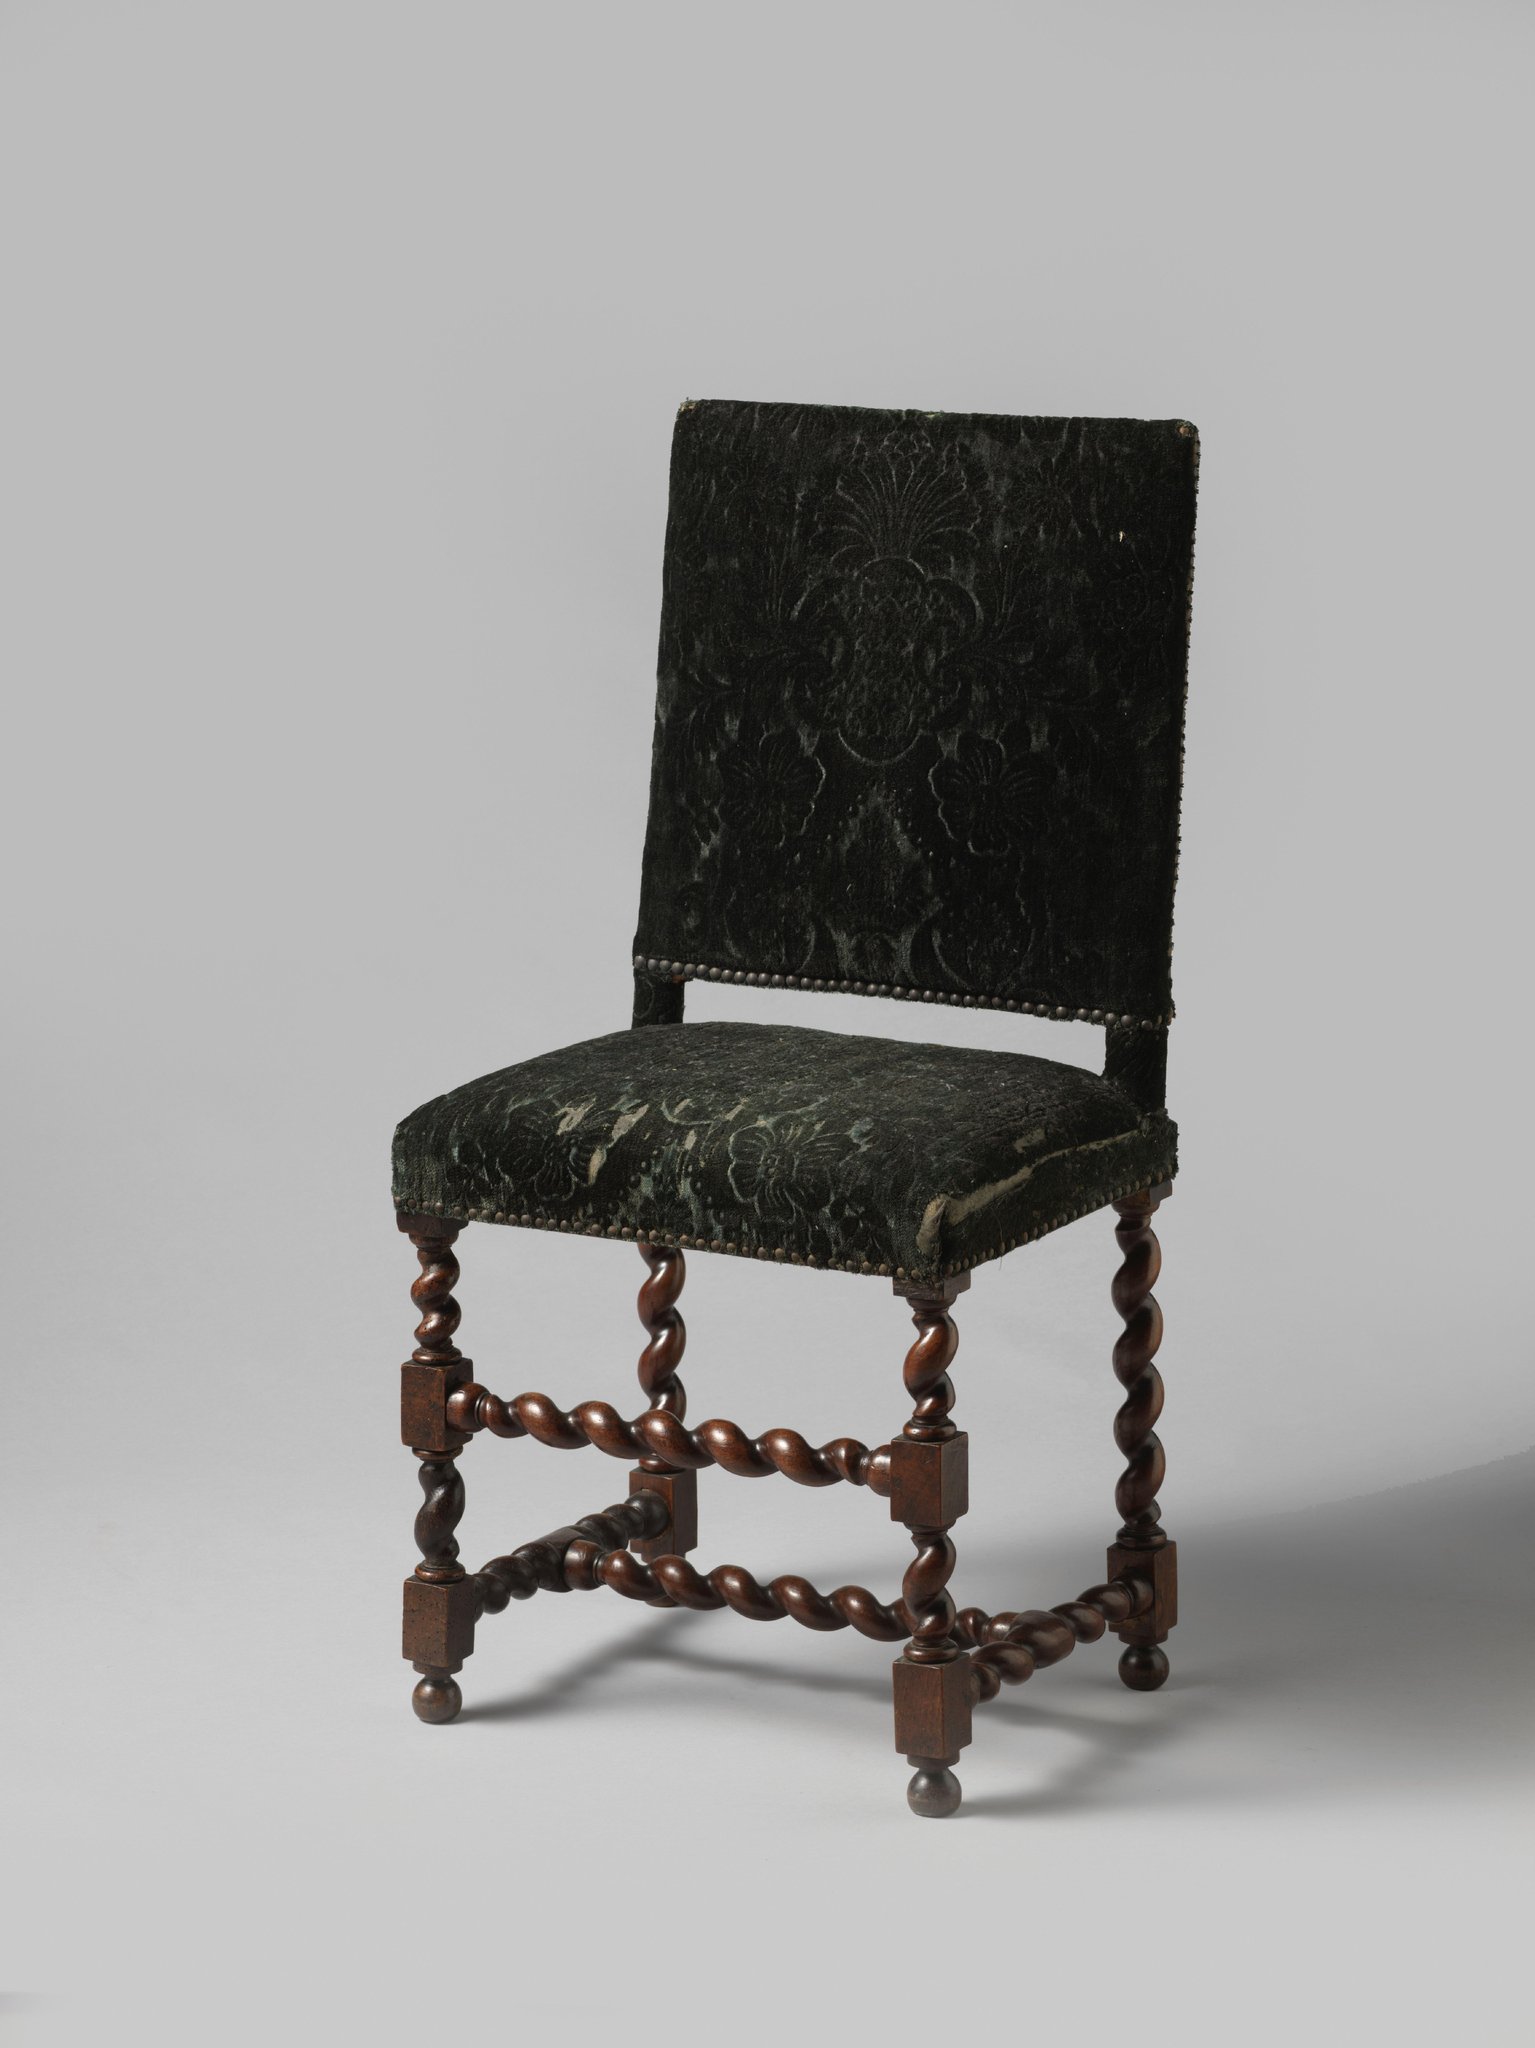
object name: chair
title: Meubilair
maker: Anonymous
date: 1650-1700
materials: velvet, wood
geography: northern netherlands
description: Chair. Walnut. Netherlands, c. 1650-1685. On loan from the Royal Antiquarian Society. Legacy of Nicolaas Pieneman, 1860.